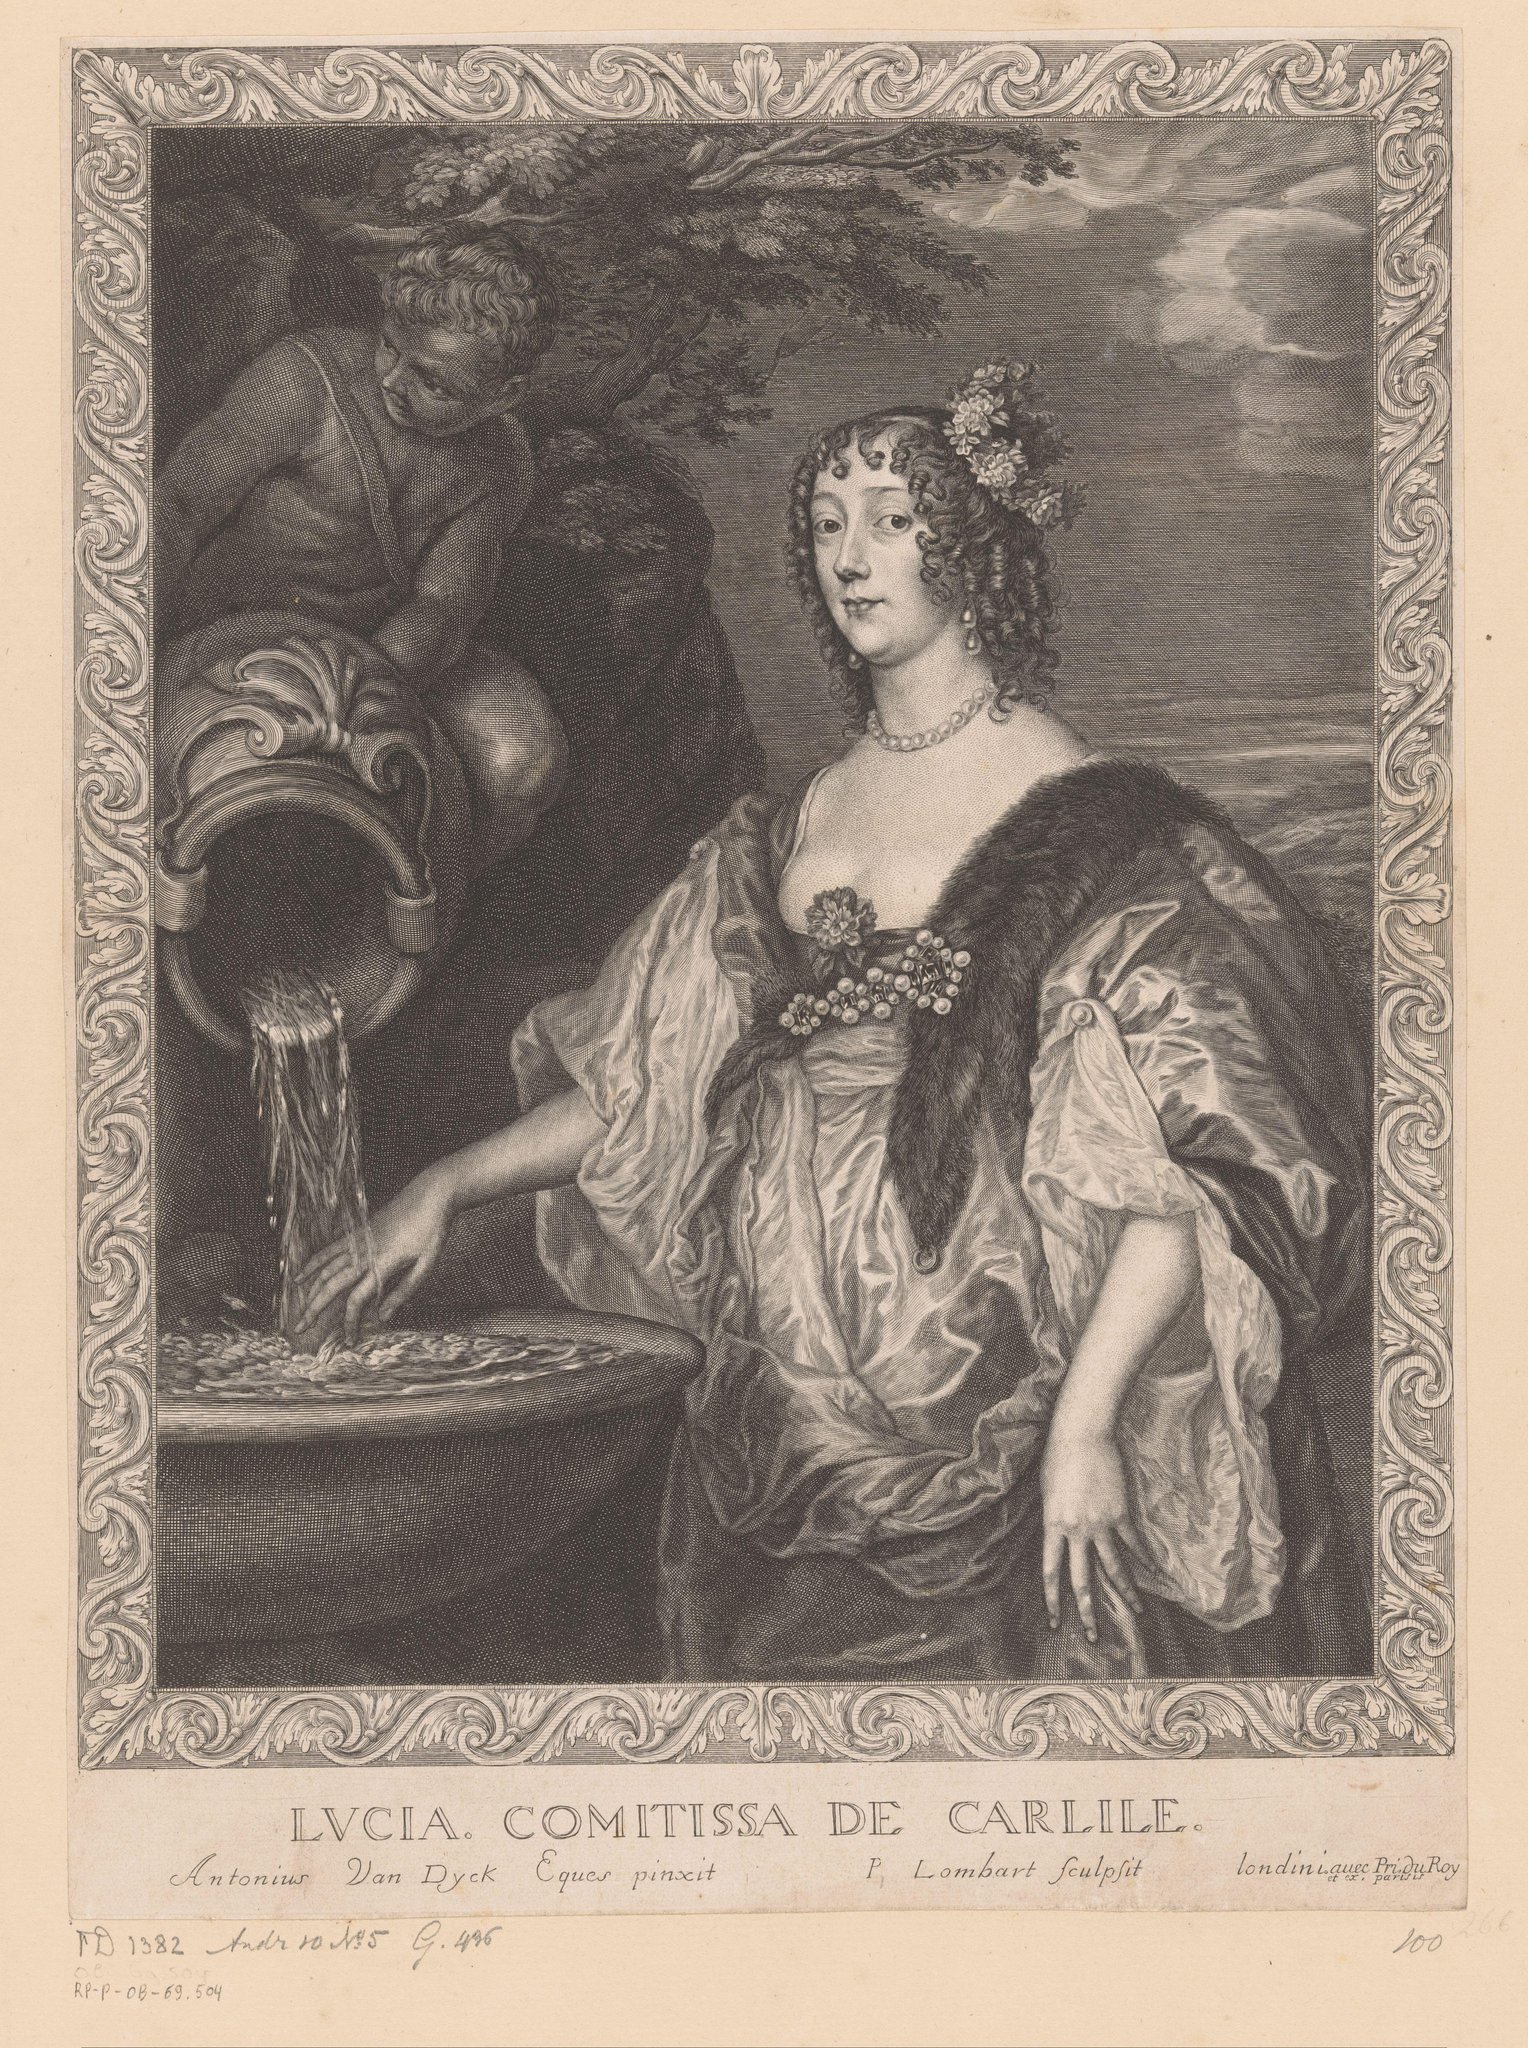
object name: print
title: Portretten van graven en gravinnen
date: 1660-1663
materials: paper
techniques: engraving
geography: paris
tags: historical persons - bb - woman, frame of painting, etc., nobility and patriciate; chivalry, knighthood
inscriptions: collector's mark: Lugt 240